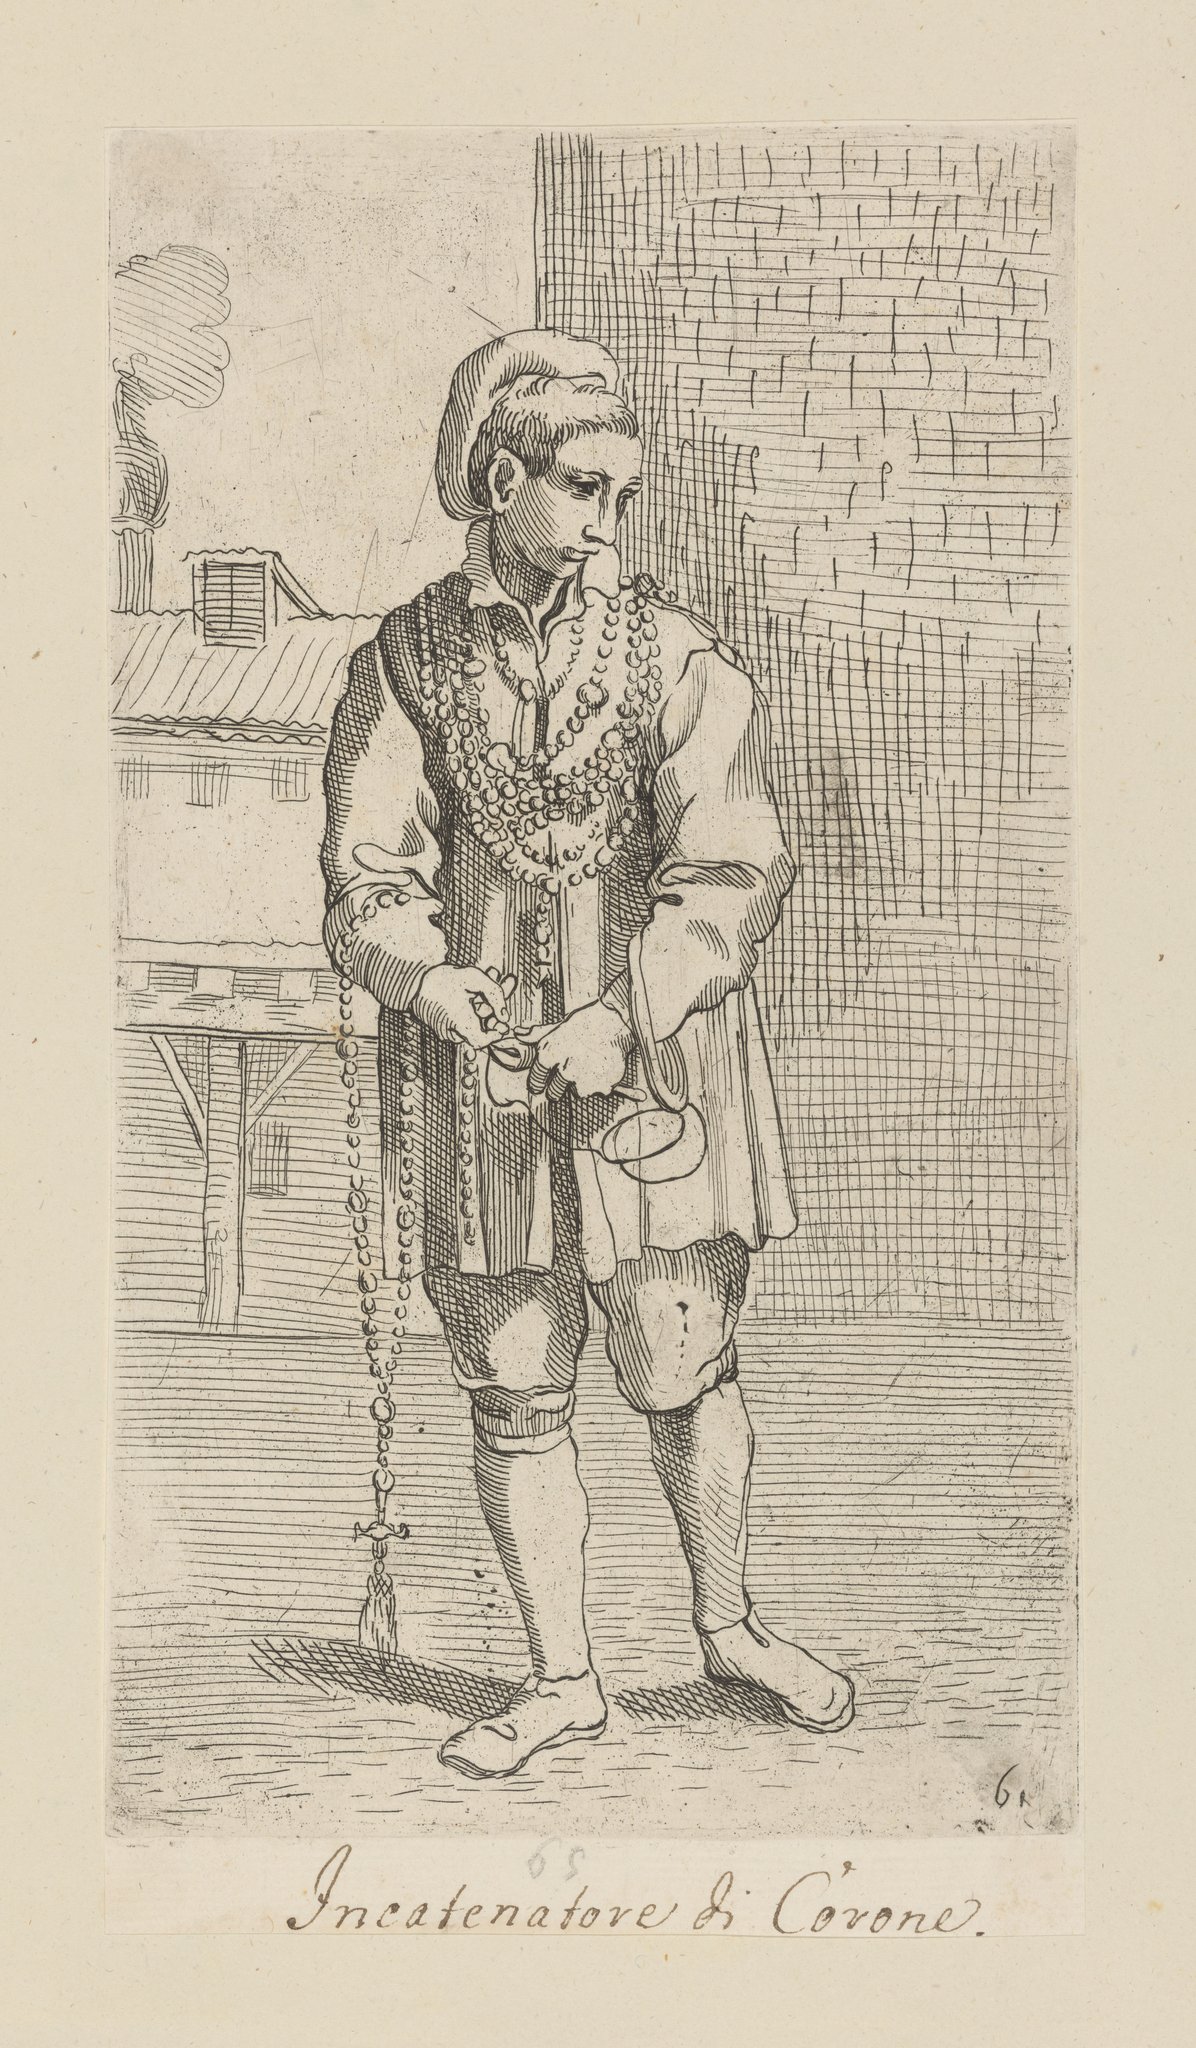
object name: print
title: Plate 61: Maker/vendor of rosaries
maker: simon guillain ii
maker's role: artist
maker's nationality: french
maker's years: 1618-1718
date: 1646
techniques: etching